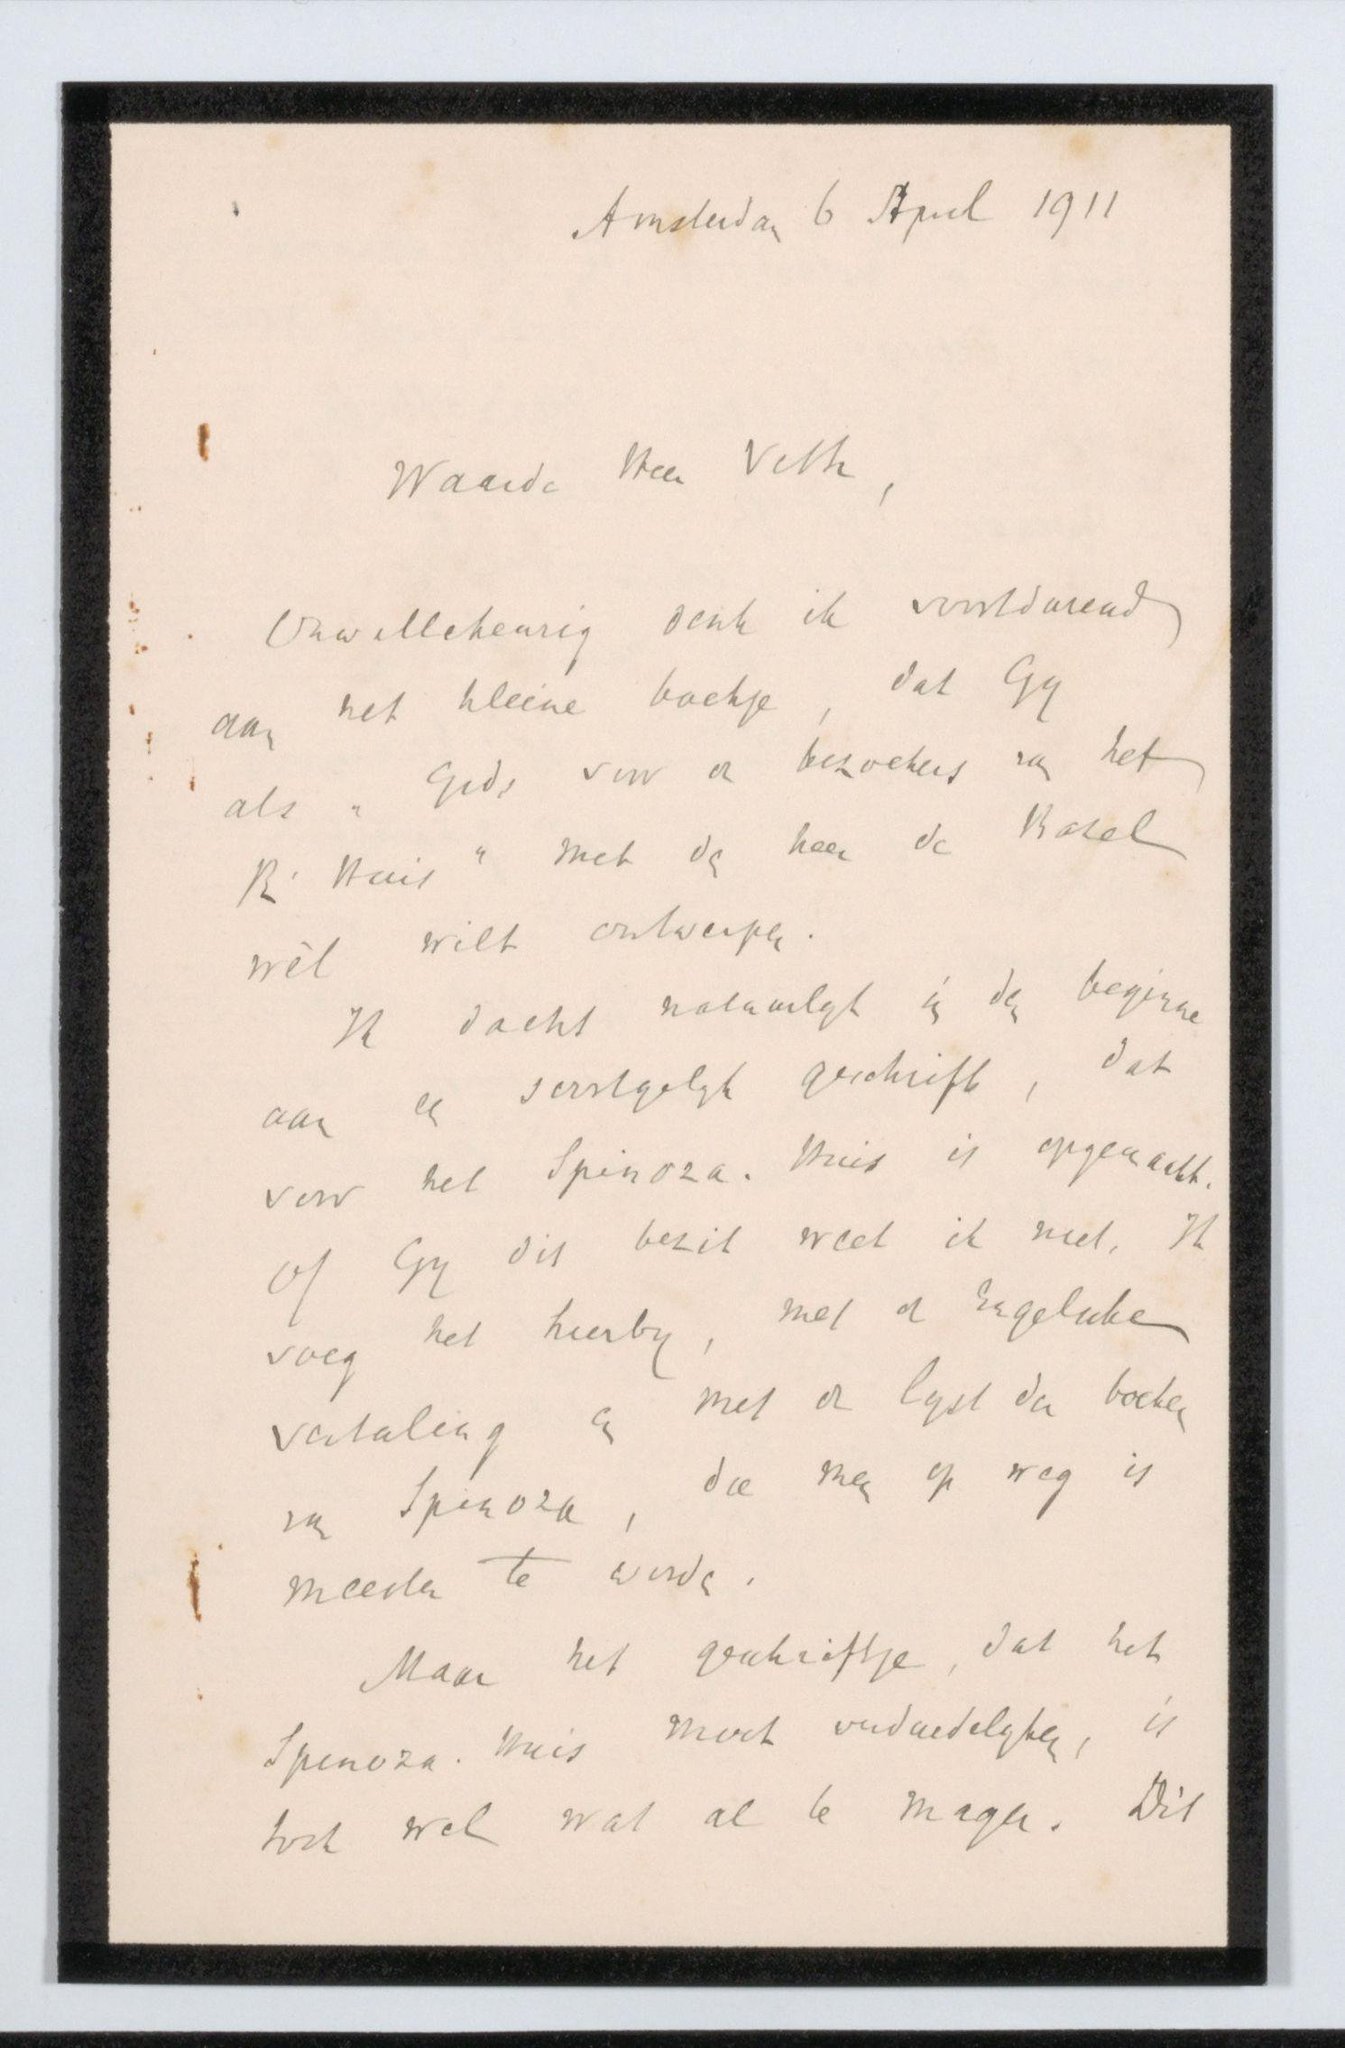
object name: letter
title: Brief aan Jan Veth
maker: hendrick peter godfried quack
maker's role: econoom, geschiedschrijver, hoogleraar, jurist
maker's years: 1834-1917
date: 1911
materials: ink, paper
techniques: pen, writing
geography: amsterdam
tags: dordrecht, painter, designer, jan veth, den helder, print maker, draughtsman, karel petrus cornelis de bazel, printed matter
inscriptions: collector's mark: ‘RPK’